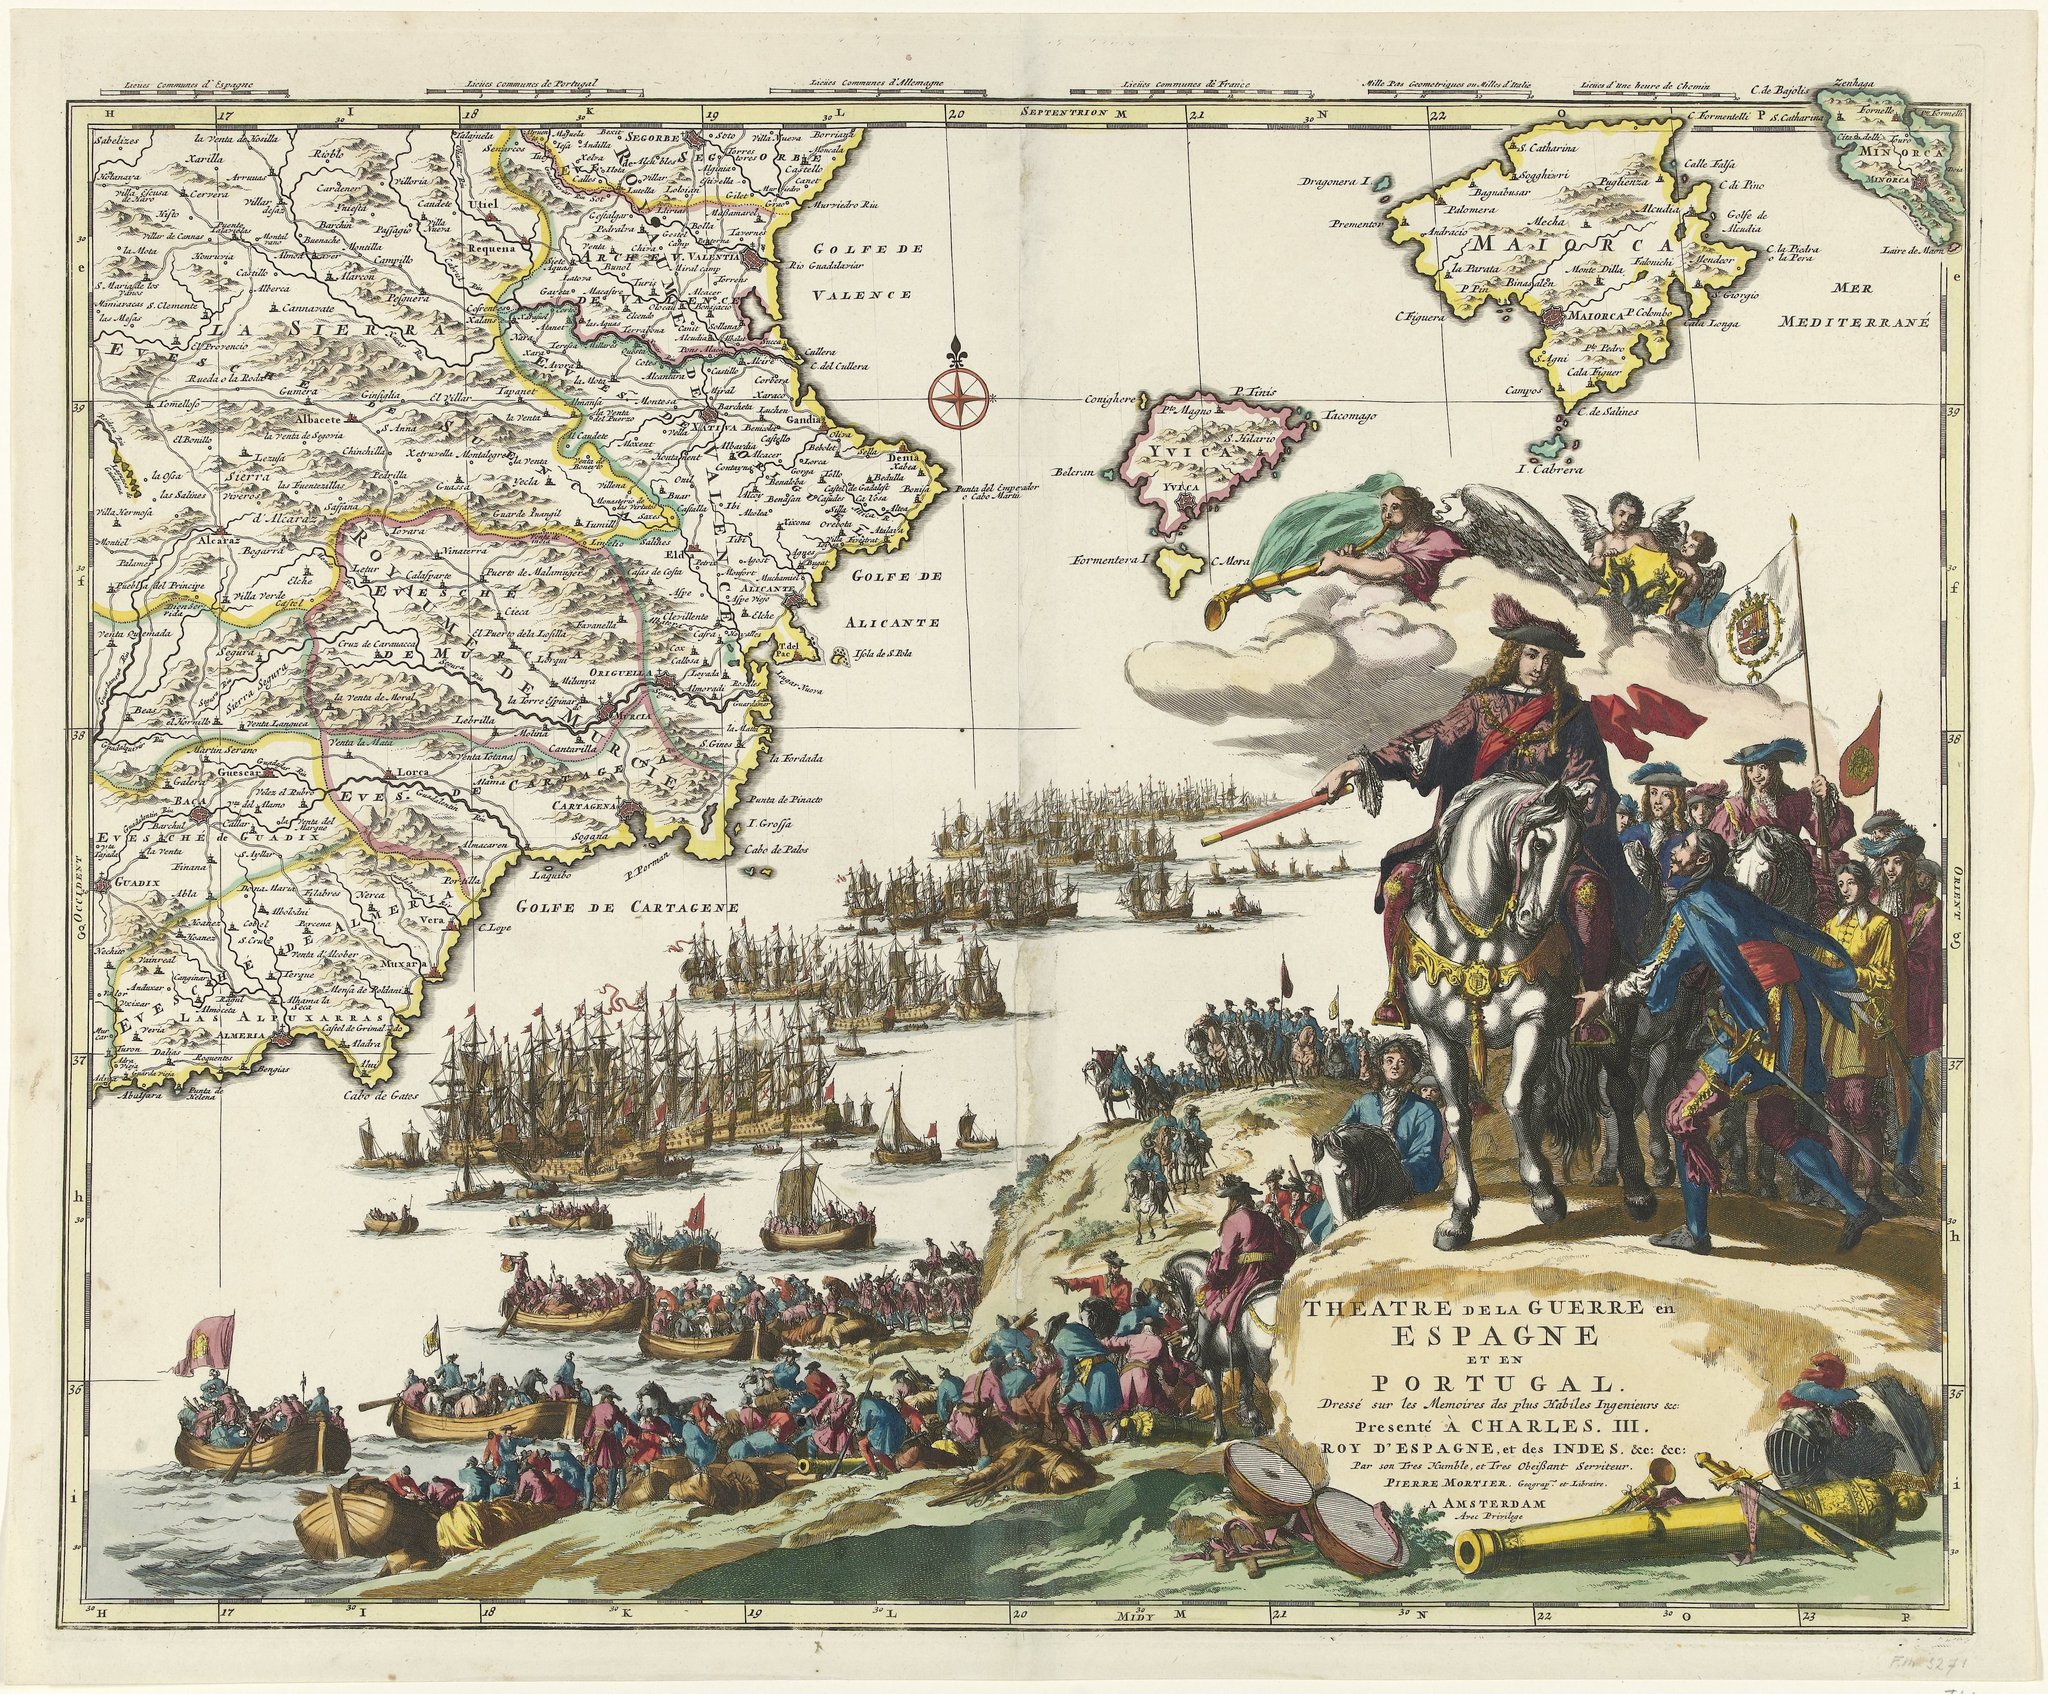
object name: print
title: Kaart van Spanje en Portugal, ca. 1703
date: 1703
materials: paper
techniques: engraving, etching, hand coloring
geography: amsterdam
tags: vienna, charles vi (holy roman emperor), maps of separate countries or regions, warfare; military affairs (+ landing, disembarkation of armed forces), spain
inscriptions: collector's mark: Lugt 2228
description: Kaart met een deel van de Spaanse oost- en zuidkust. Onderdeel (blad rechtsonder) van een grote kaart van Spanje en Portugal in vier bladen, ca. 1703. Vignet met koning Karel III te paard met zijn gevolg, voor hem een Spanjaard. Links de landing van Geallieerde troepen in Spanje.